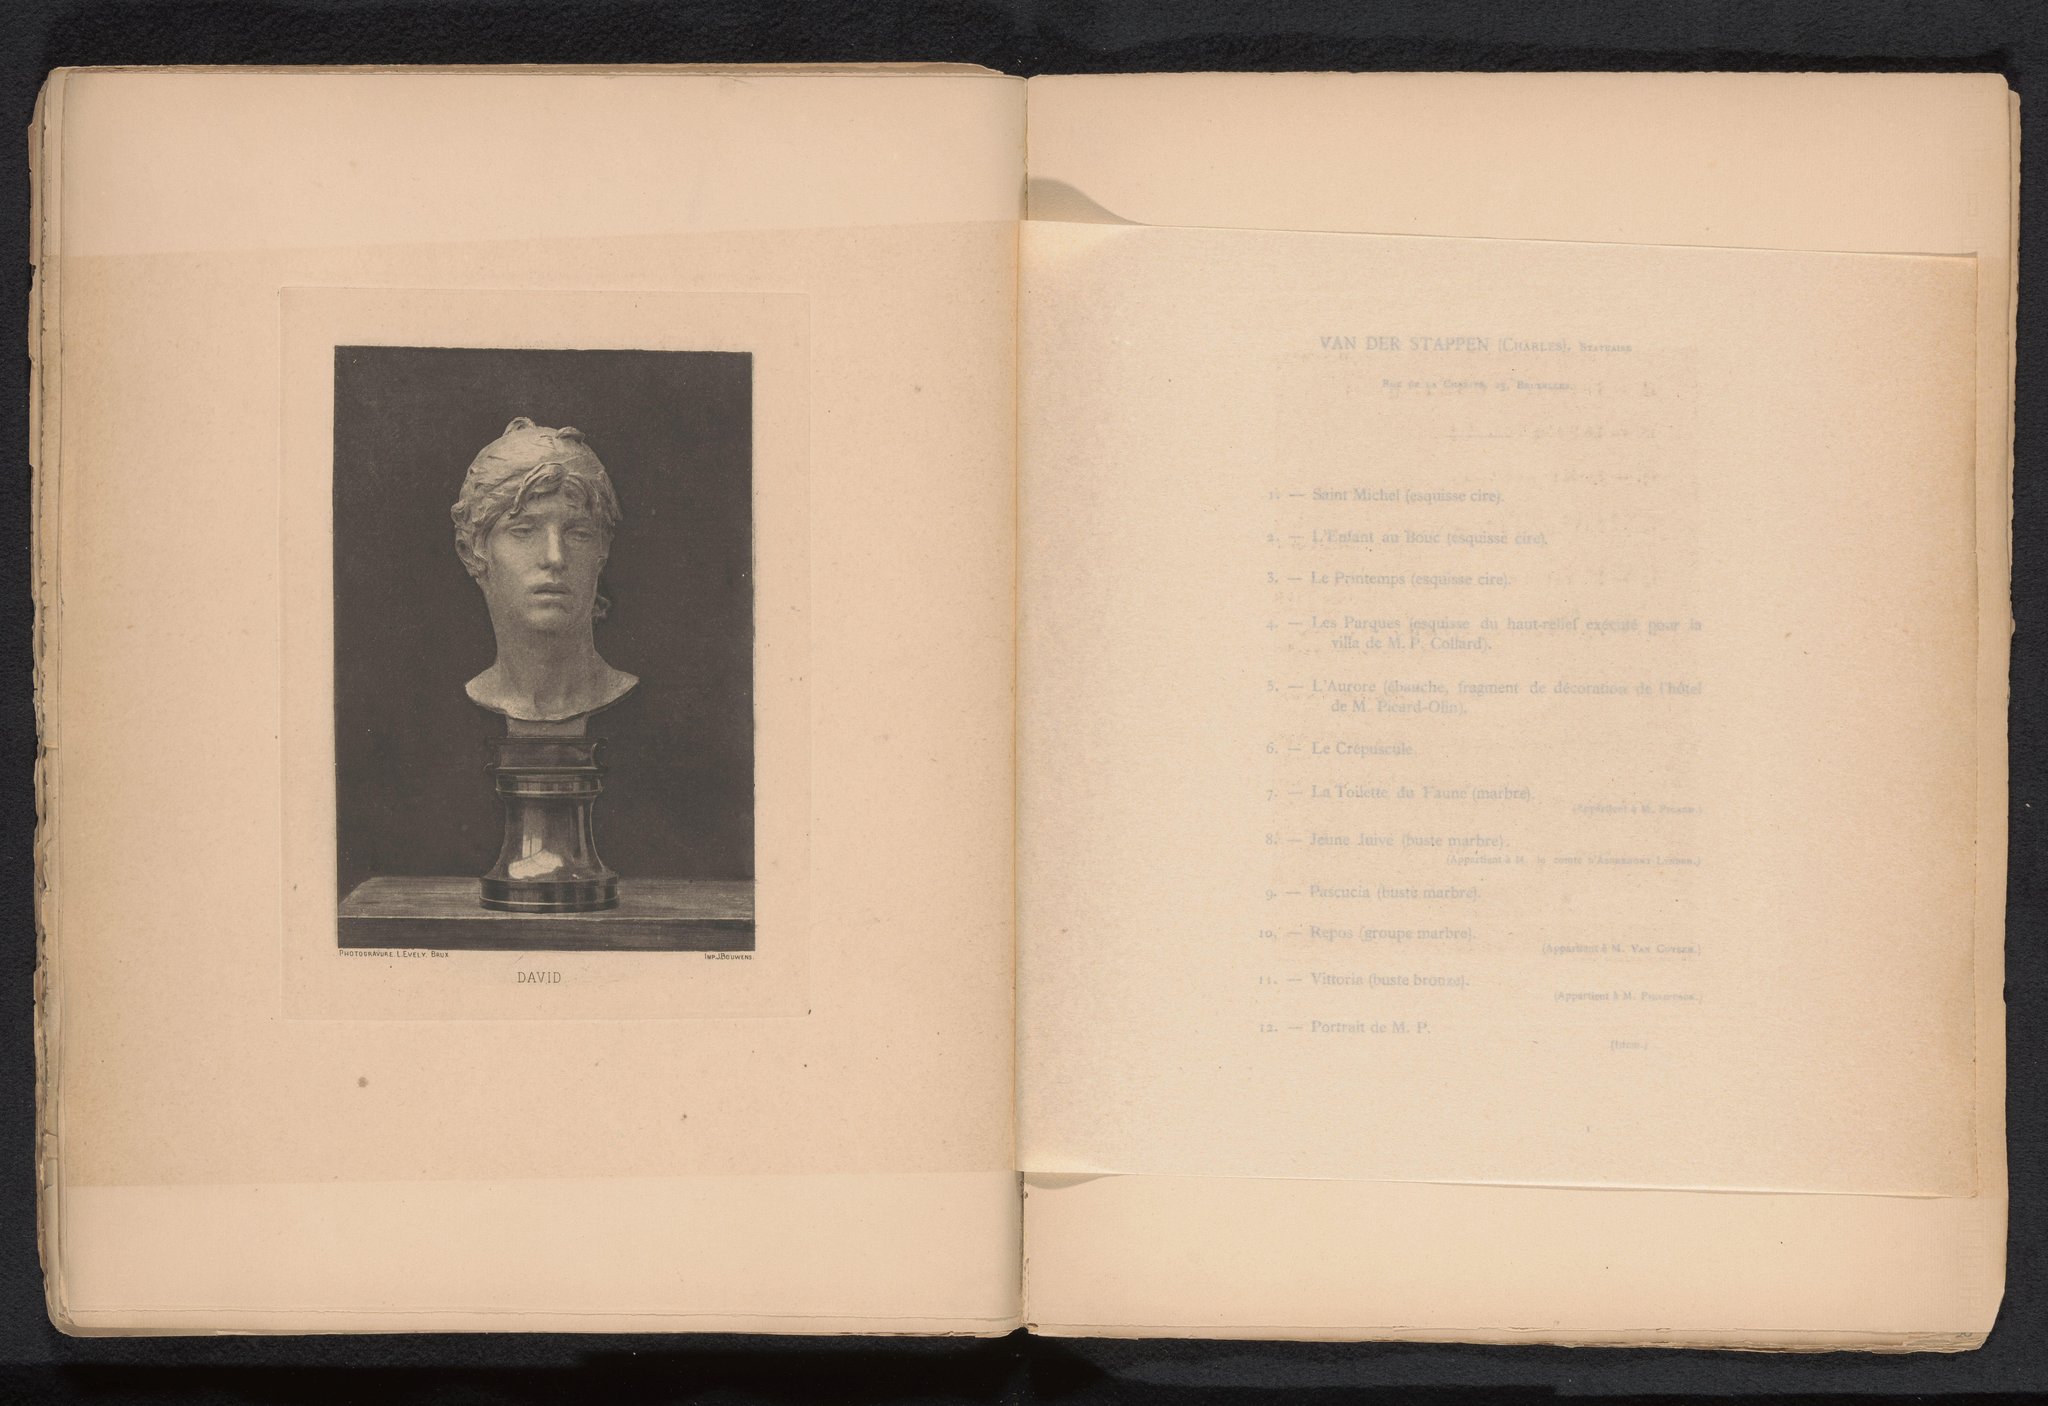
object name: photomechanical print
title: Sculptuur van het hoofd van David door Charles van der Stappen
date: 1878-1883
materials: paper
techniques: photoaquatint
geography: brussels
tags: head (human), piece of sculpture, reproduction of a piece of sculpture